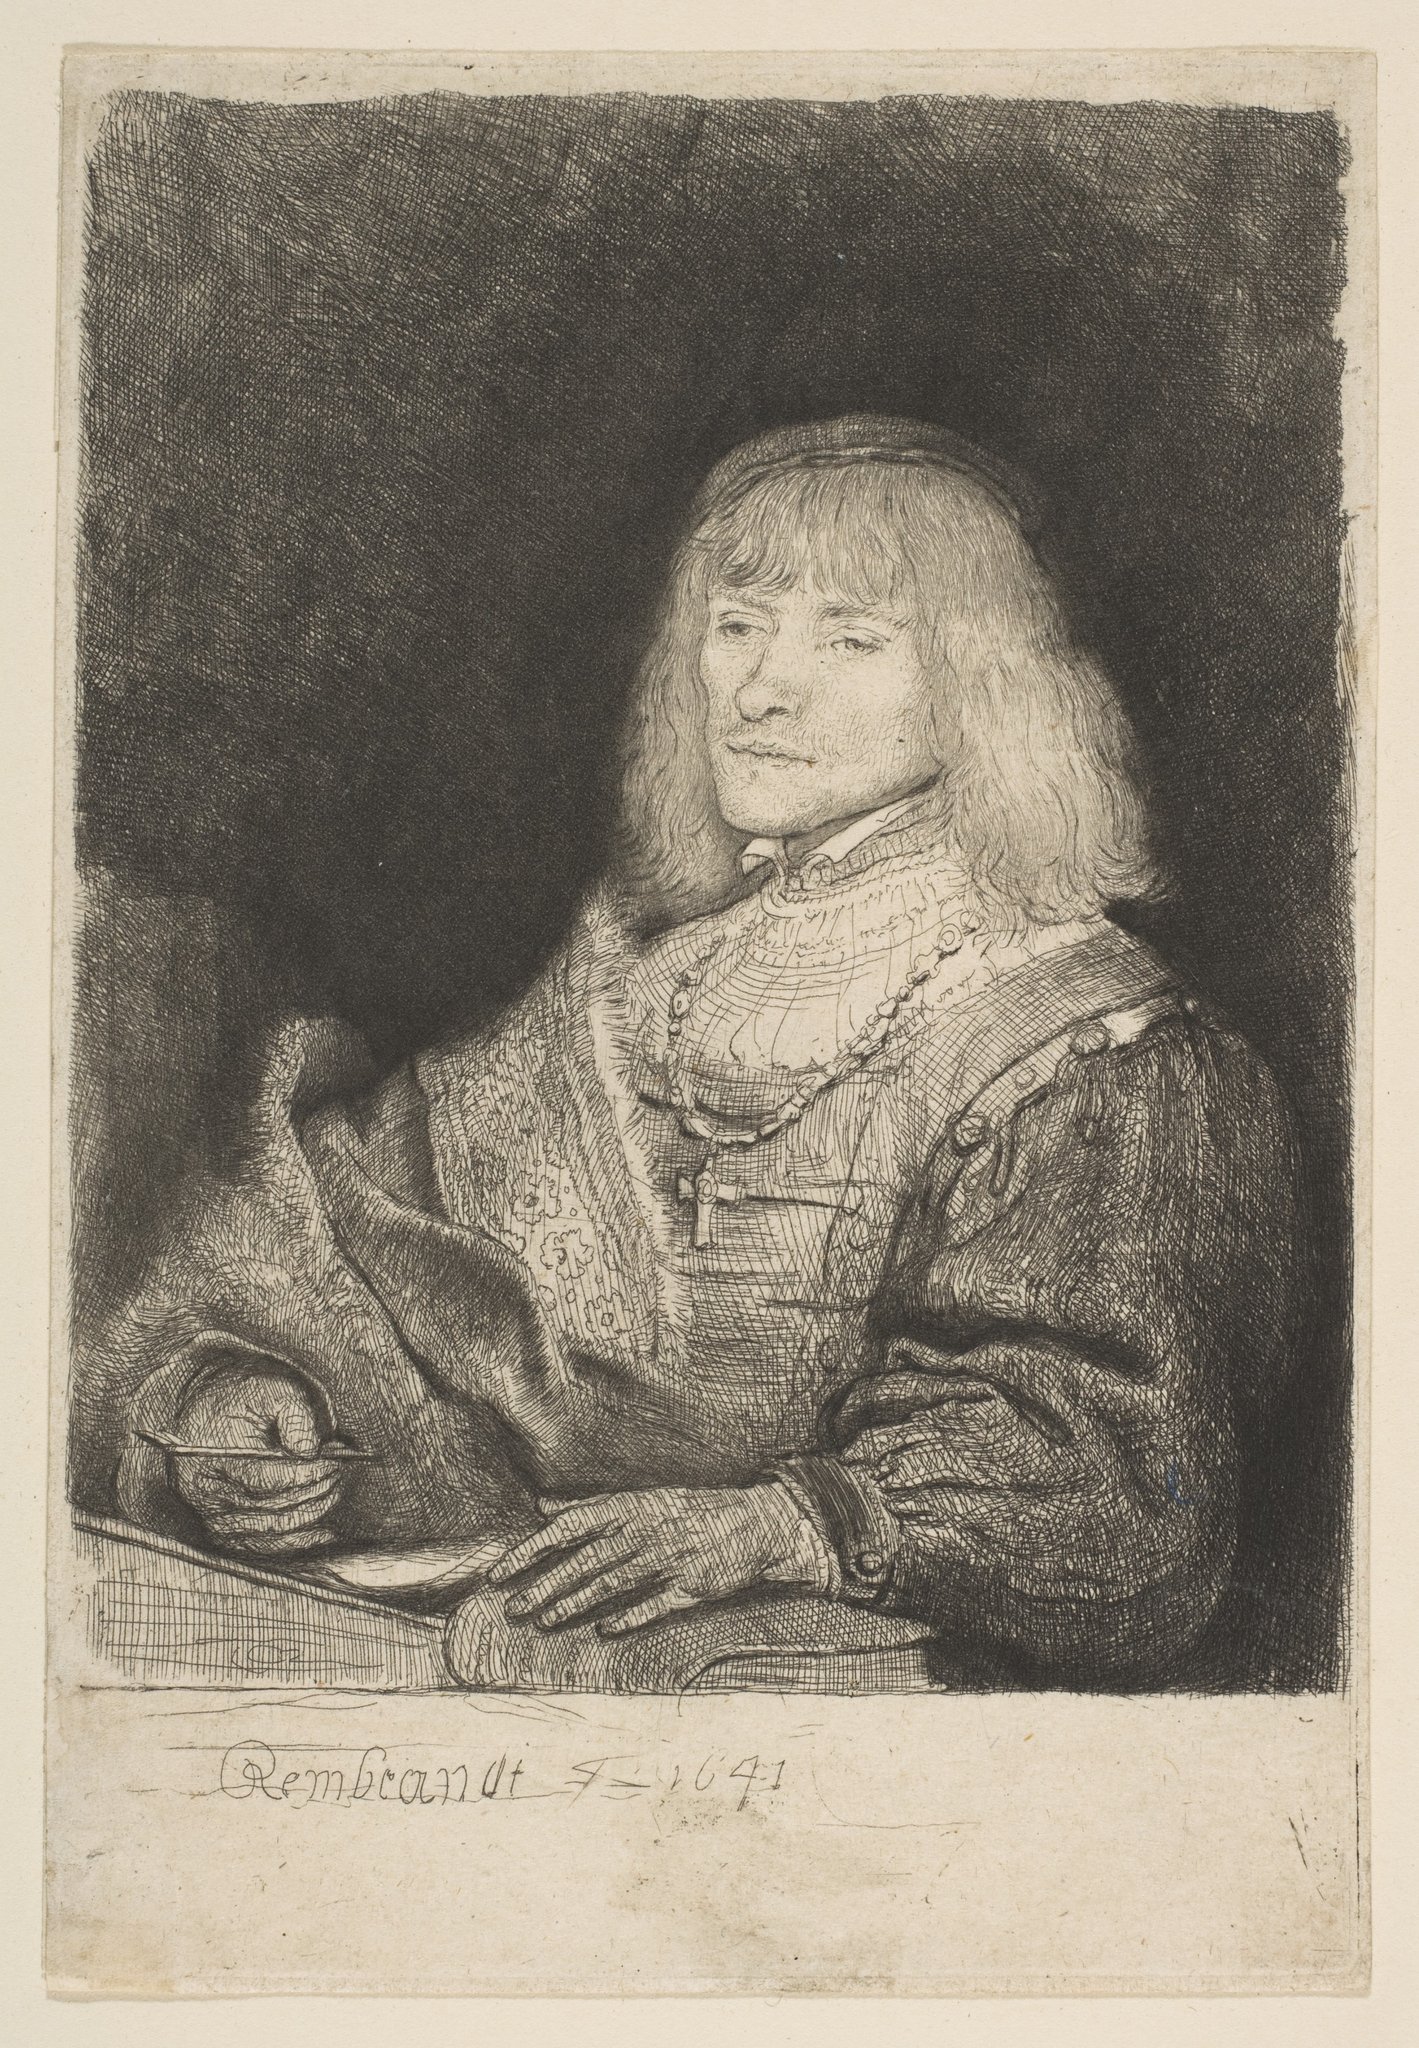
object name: print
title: Man at Desk, Wearing Cross and Chain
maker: rembrandt van rijn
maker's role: artist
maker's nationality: dutch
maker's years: 1606-1669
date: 1641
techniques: drypoint, etching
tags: men,portraits,cross